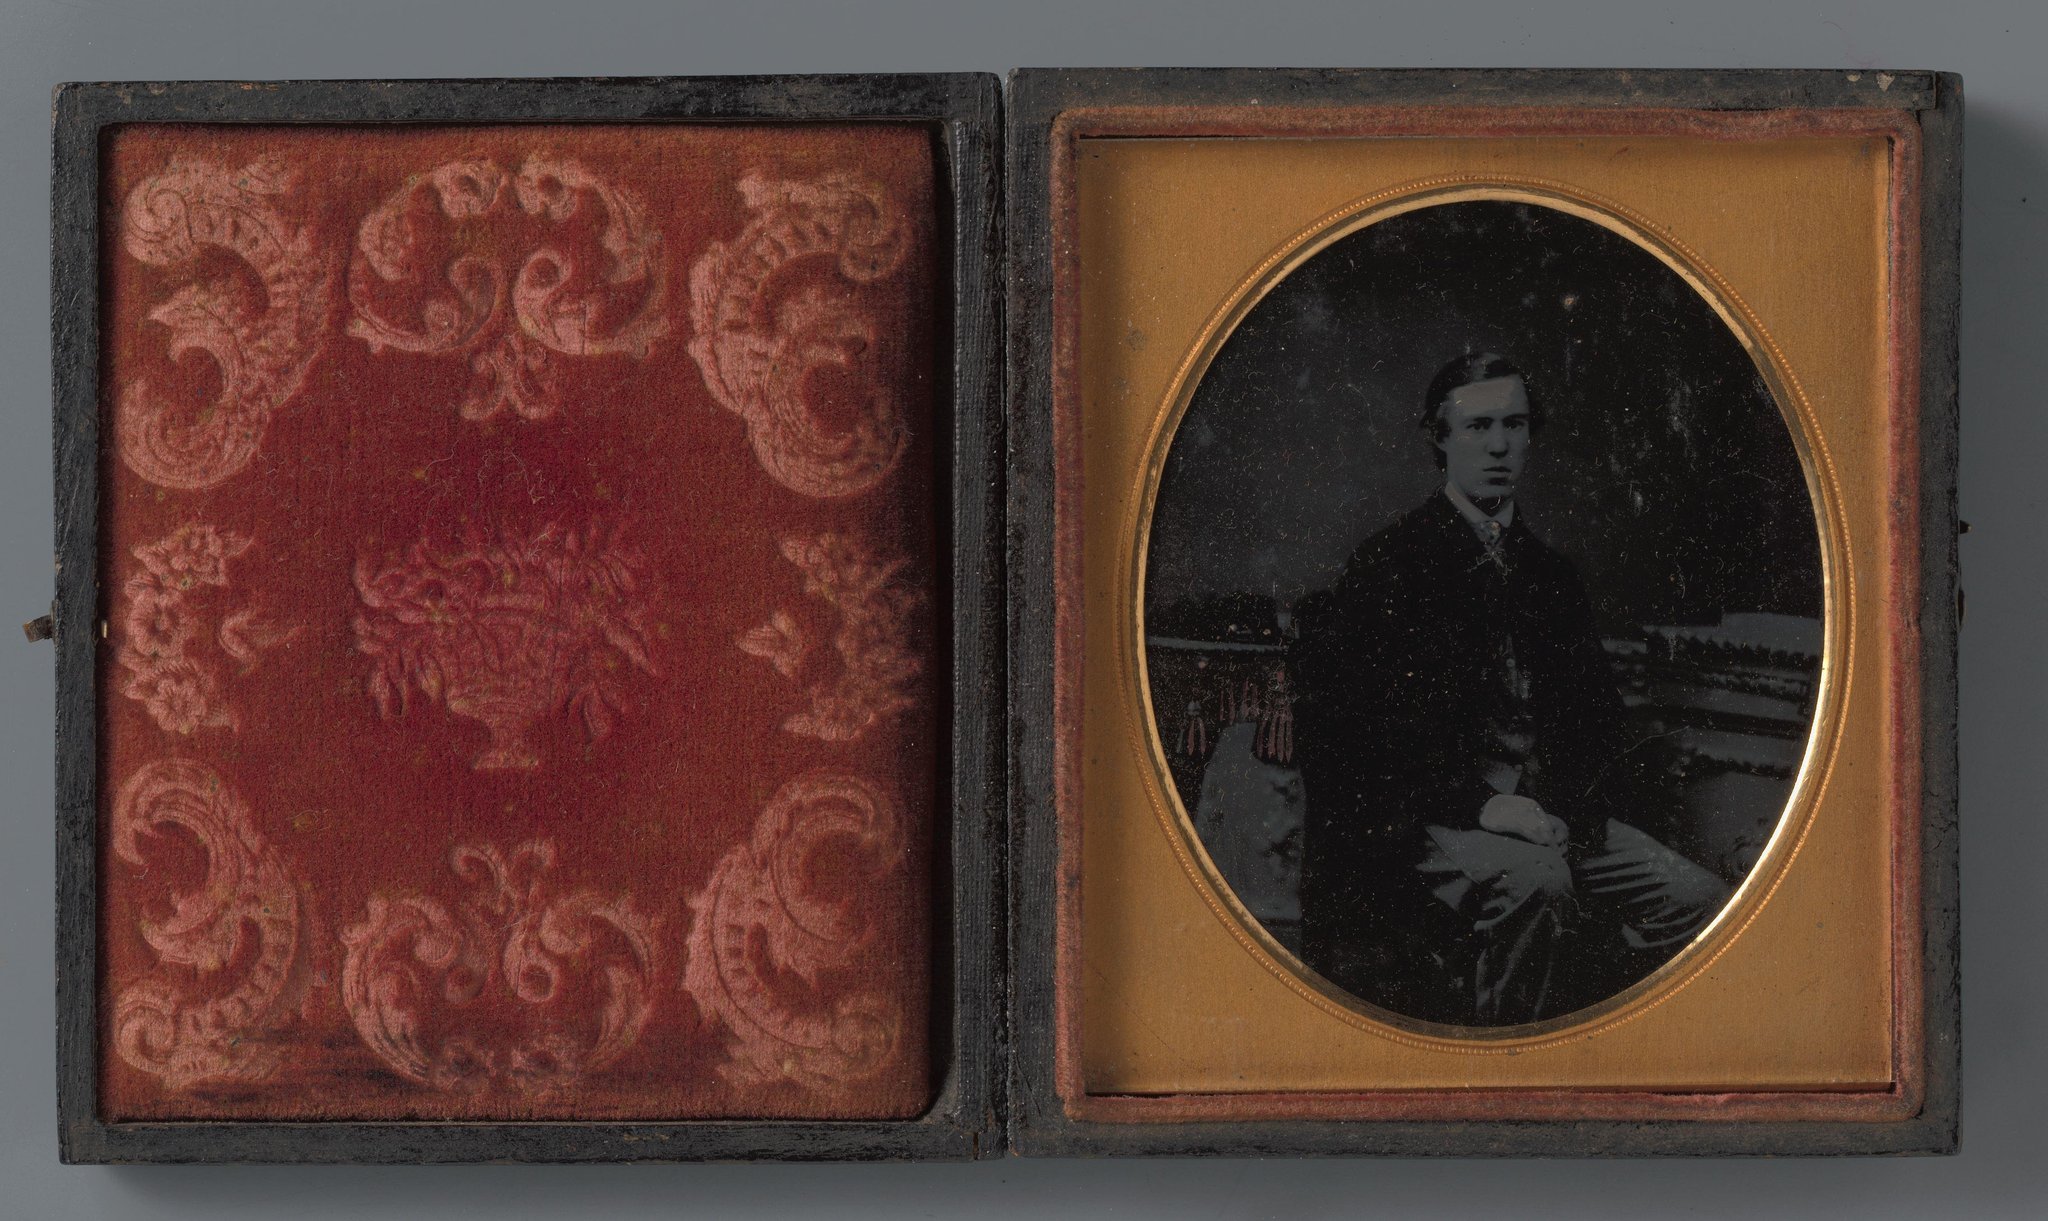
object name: photograph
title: Portret van een onbekende man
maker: Anonymous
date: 1855-1870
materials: glass, metal, velvet, wood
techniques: ambrotype, hand coloring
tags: sitting figure, adult man, historical persons